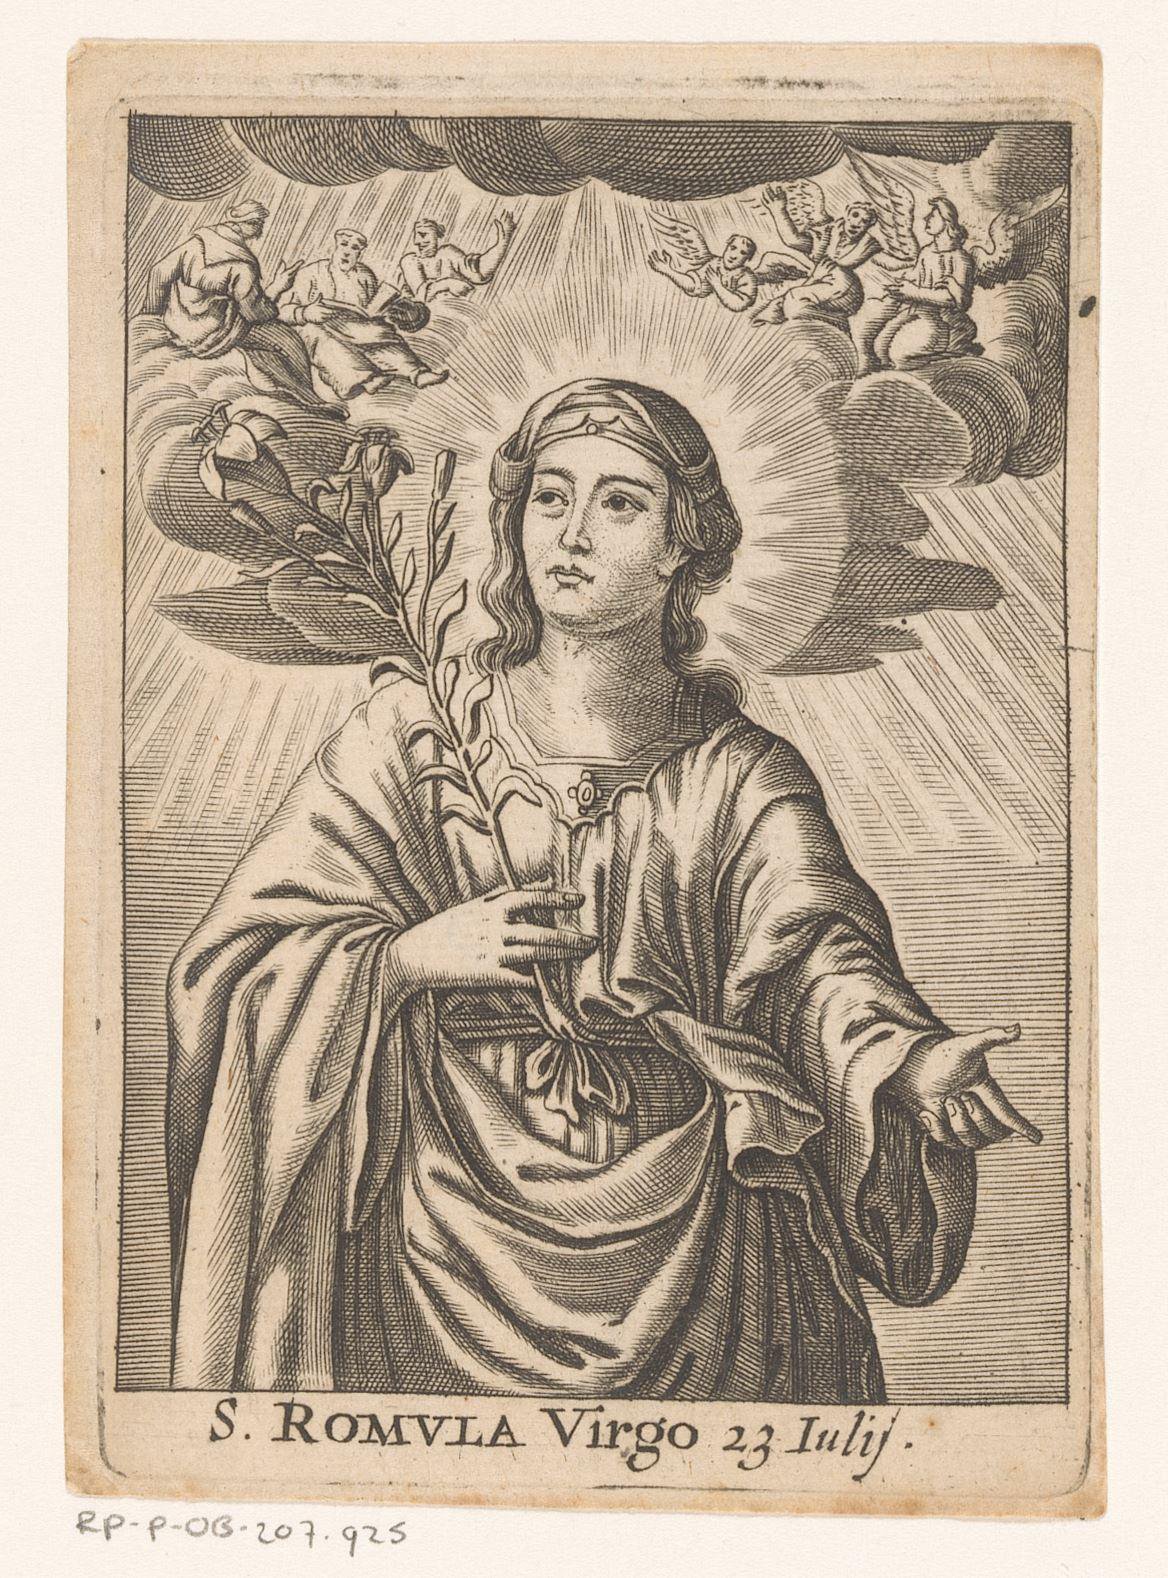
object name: print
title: Heilige maagden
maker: Anonymous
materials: paper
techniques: engraving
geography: antwerp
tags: female saints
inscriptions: collector's mark: Lugt 2228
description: Deze prent maakt deel uit van een reeks van onbekende omvang met kopieën naar prenten door Pieter de Jode I naar ontwerp van Jan van Mechelen. De prenten door Pieter de Jode werden gebruikt voor de publicatie: Rosweyde, Heribertus. Het leven der HH. Maeghden. Antwerpen: Jan Cnobbaert, 1626.